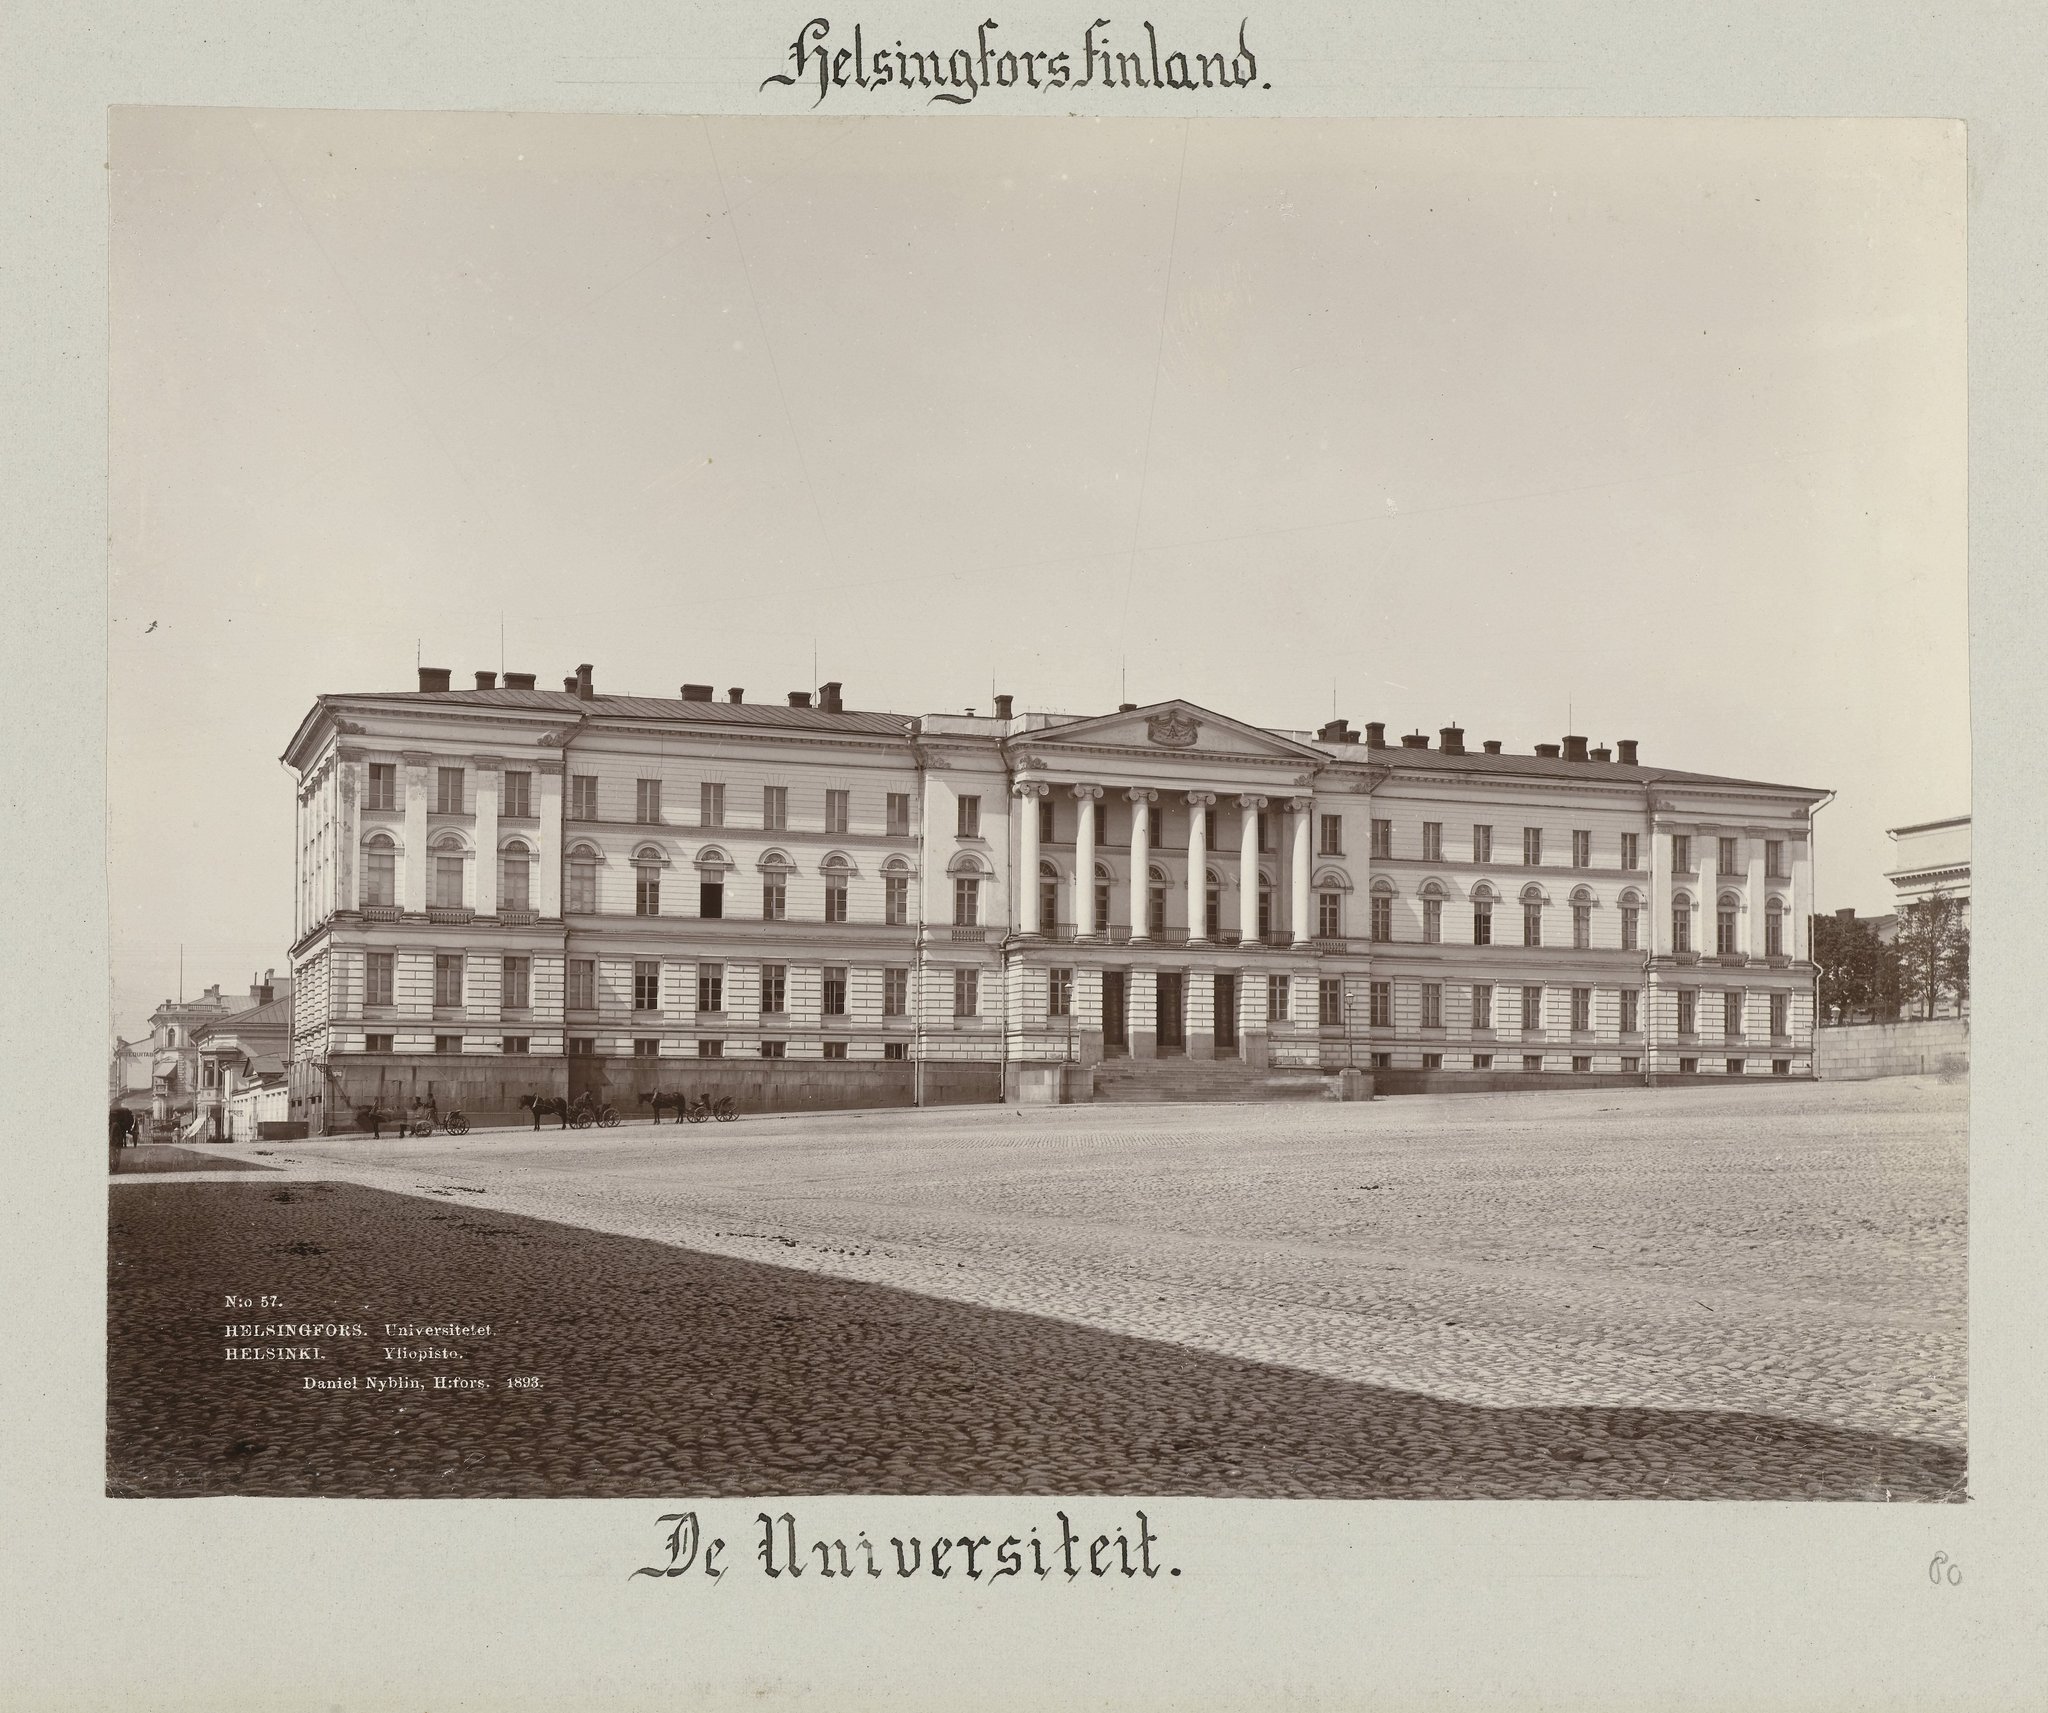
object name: photograph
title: No 57 Helsingfors Universitetet, Daniel Nyblin 1890.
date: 1898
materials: paper, photographic support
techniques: albumen print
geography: helsinki